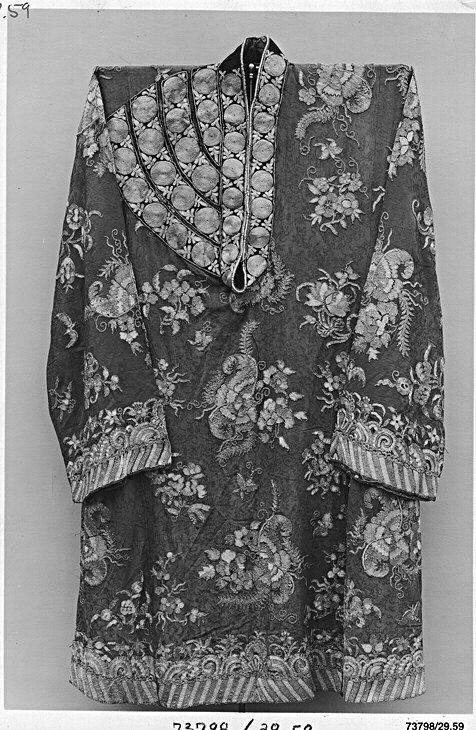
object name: robe, presentation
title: Presentation Robe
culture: chinese or turkestani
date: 1801-1900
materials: silk